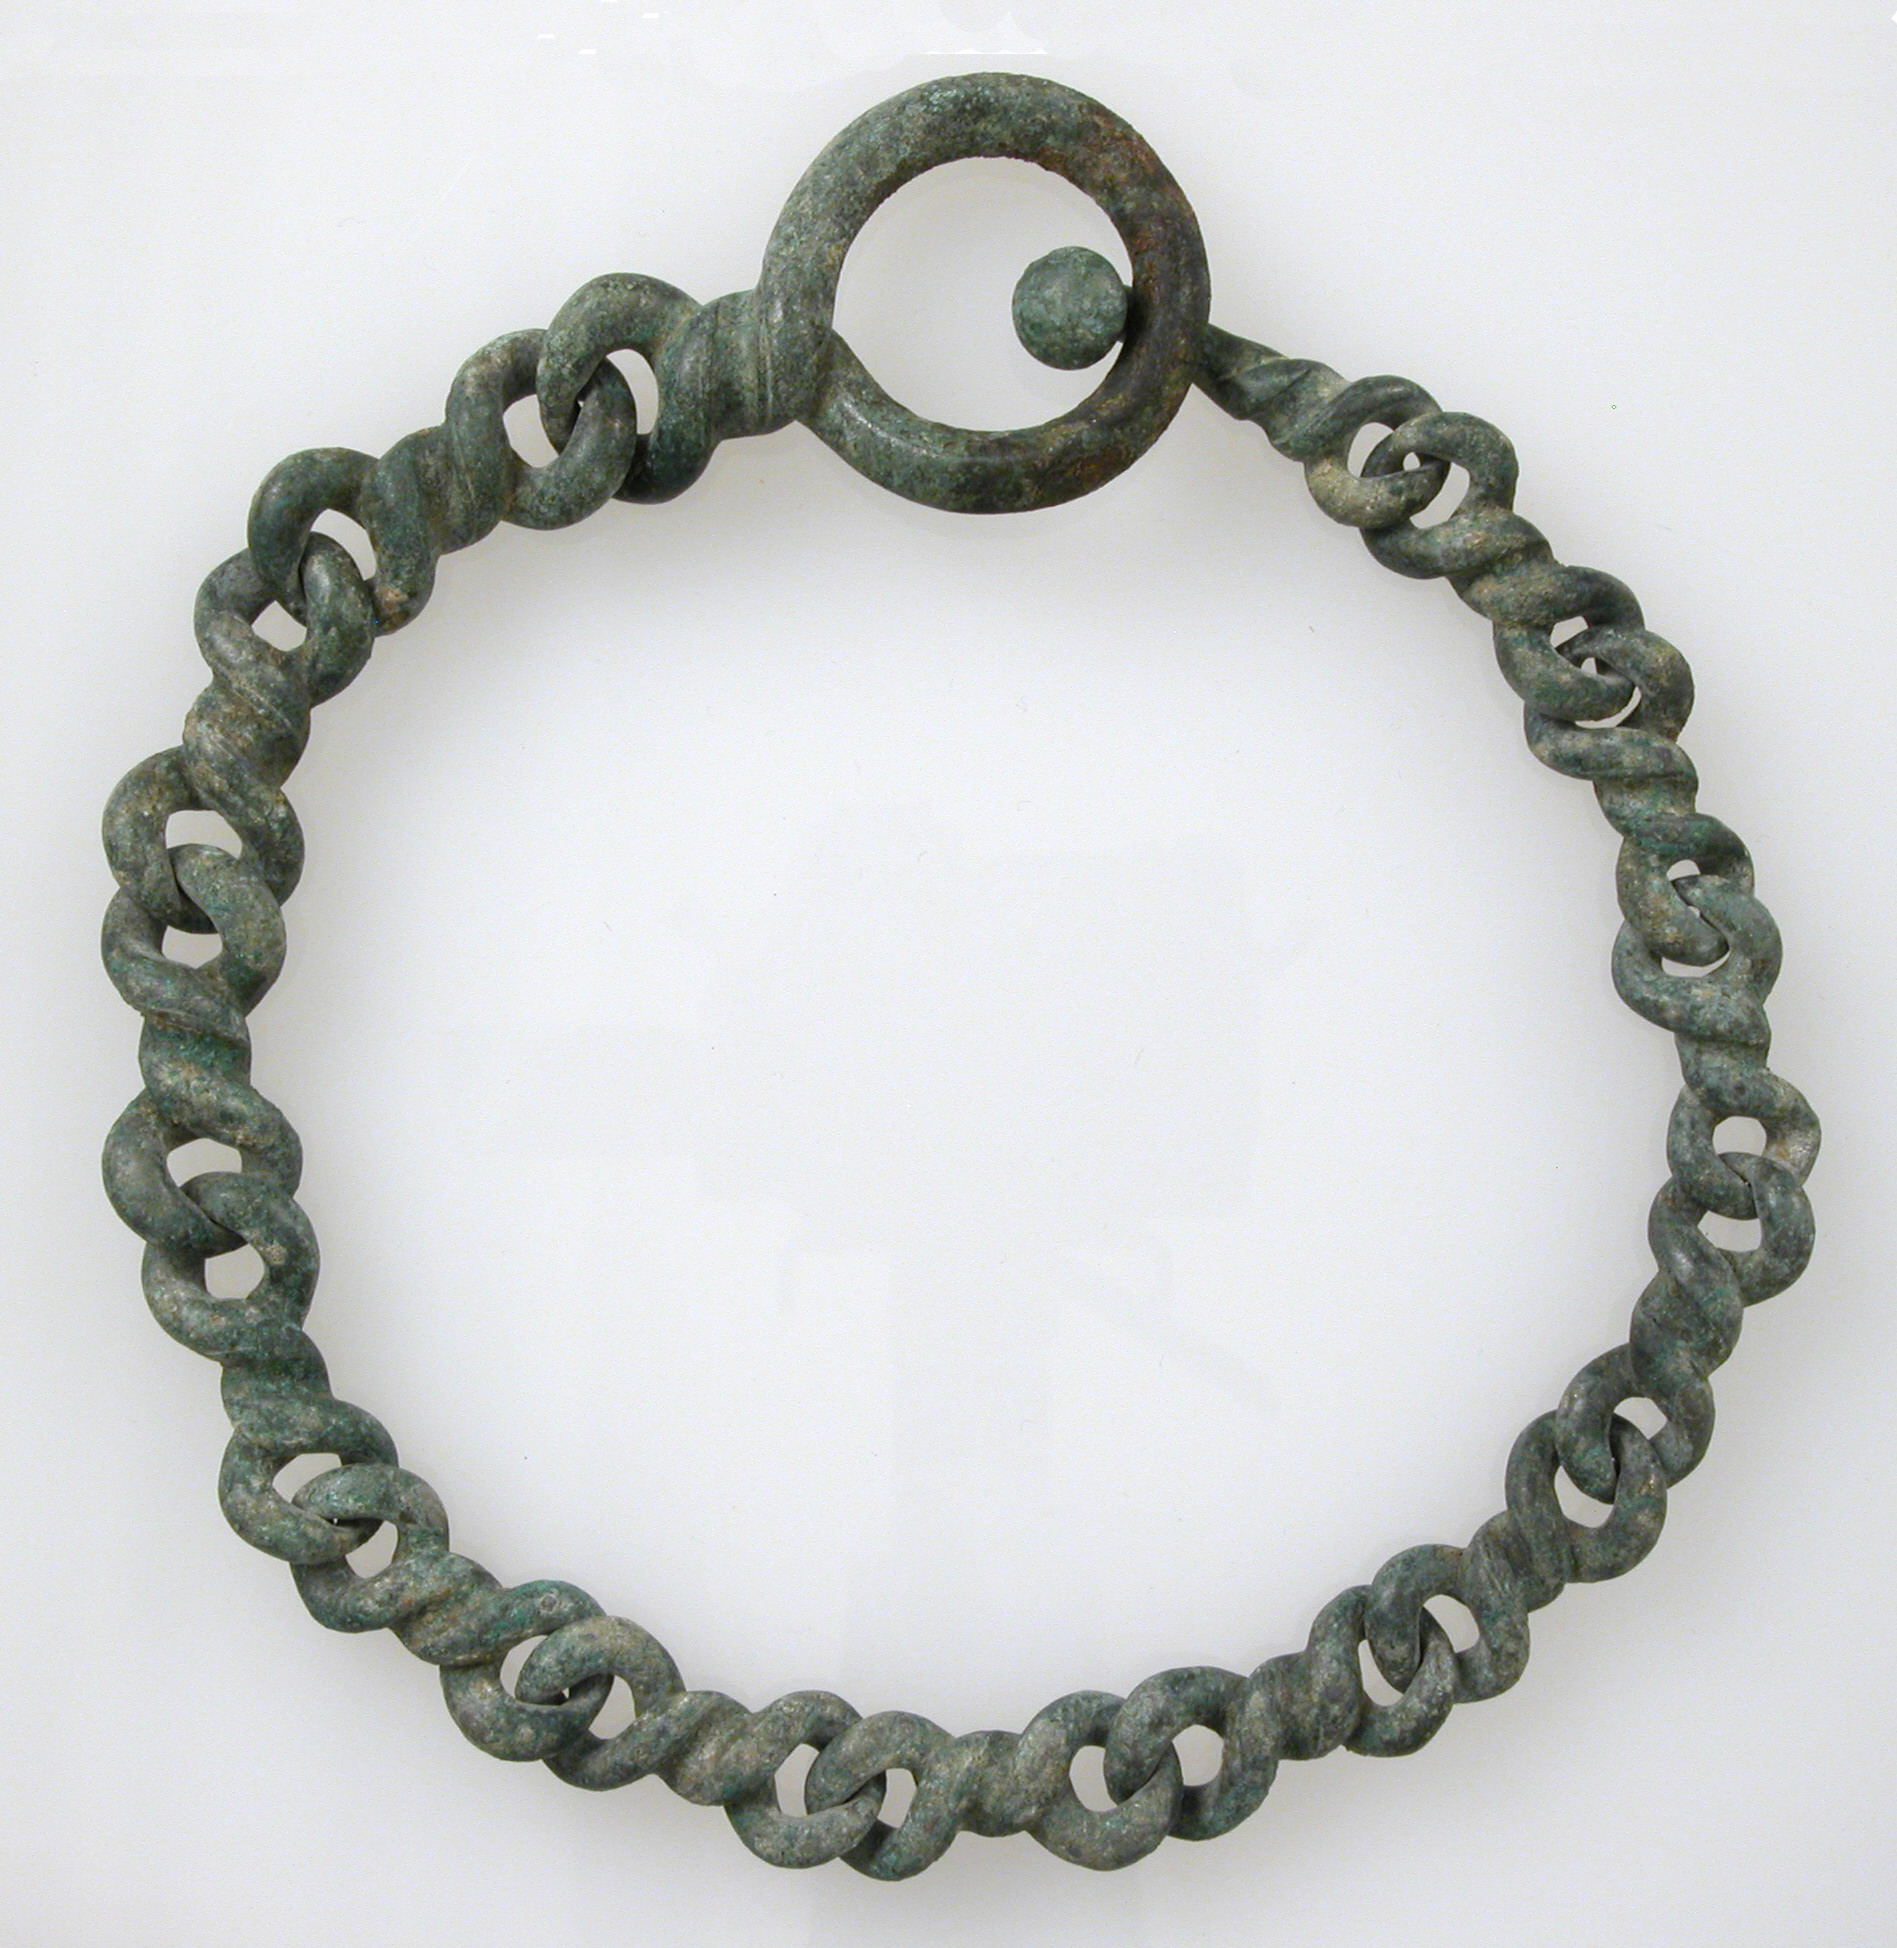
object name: sword chain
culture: celtic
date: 400-301 BCE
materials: copper alloy